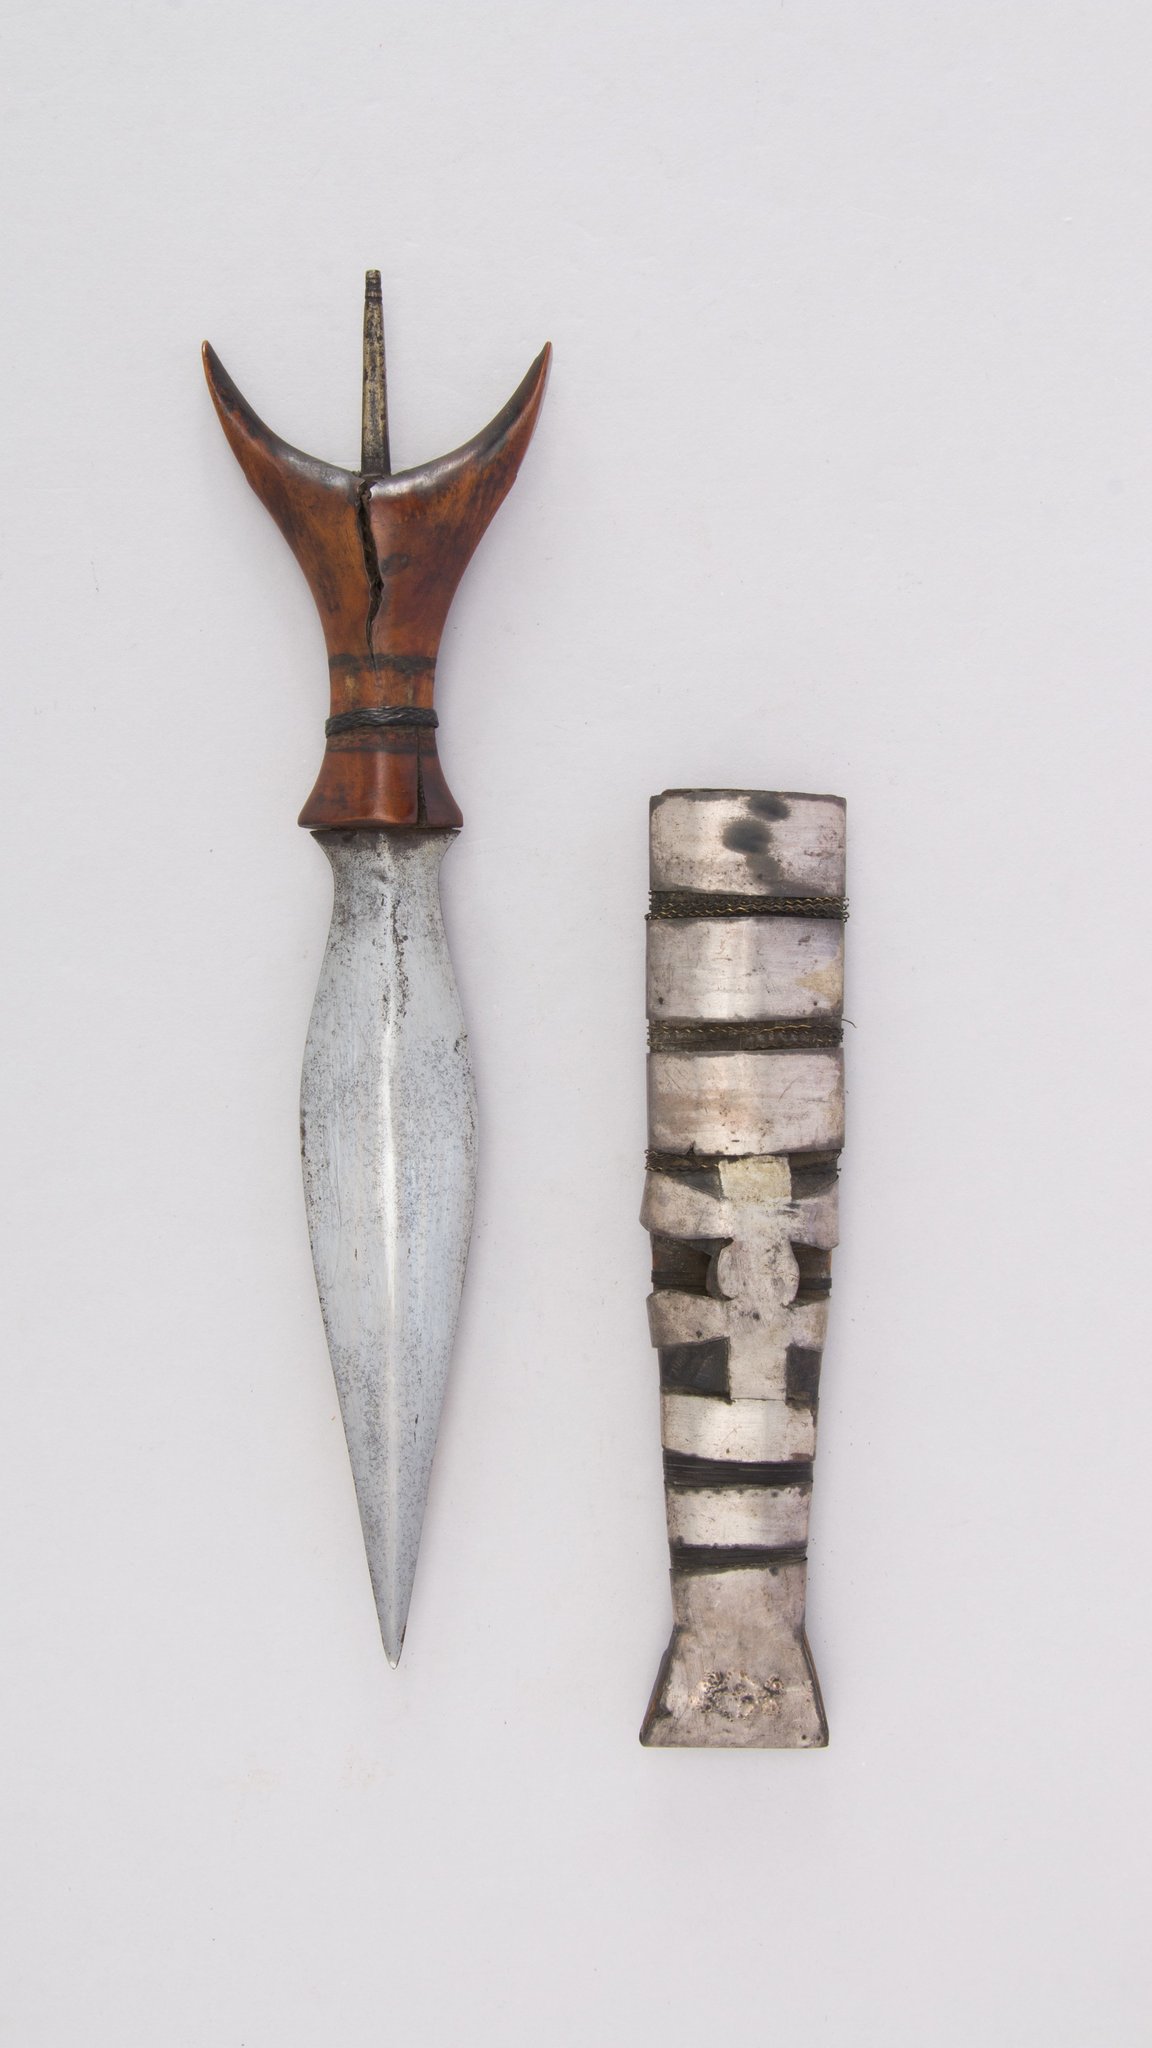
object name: dagger with sheath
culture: philippine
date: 1801-1900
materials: brass, leather, silver, steel, shell, metal, wood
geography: philippines